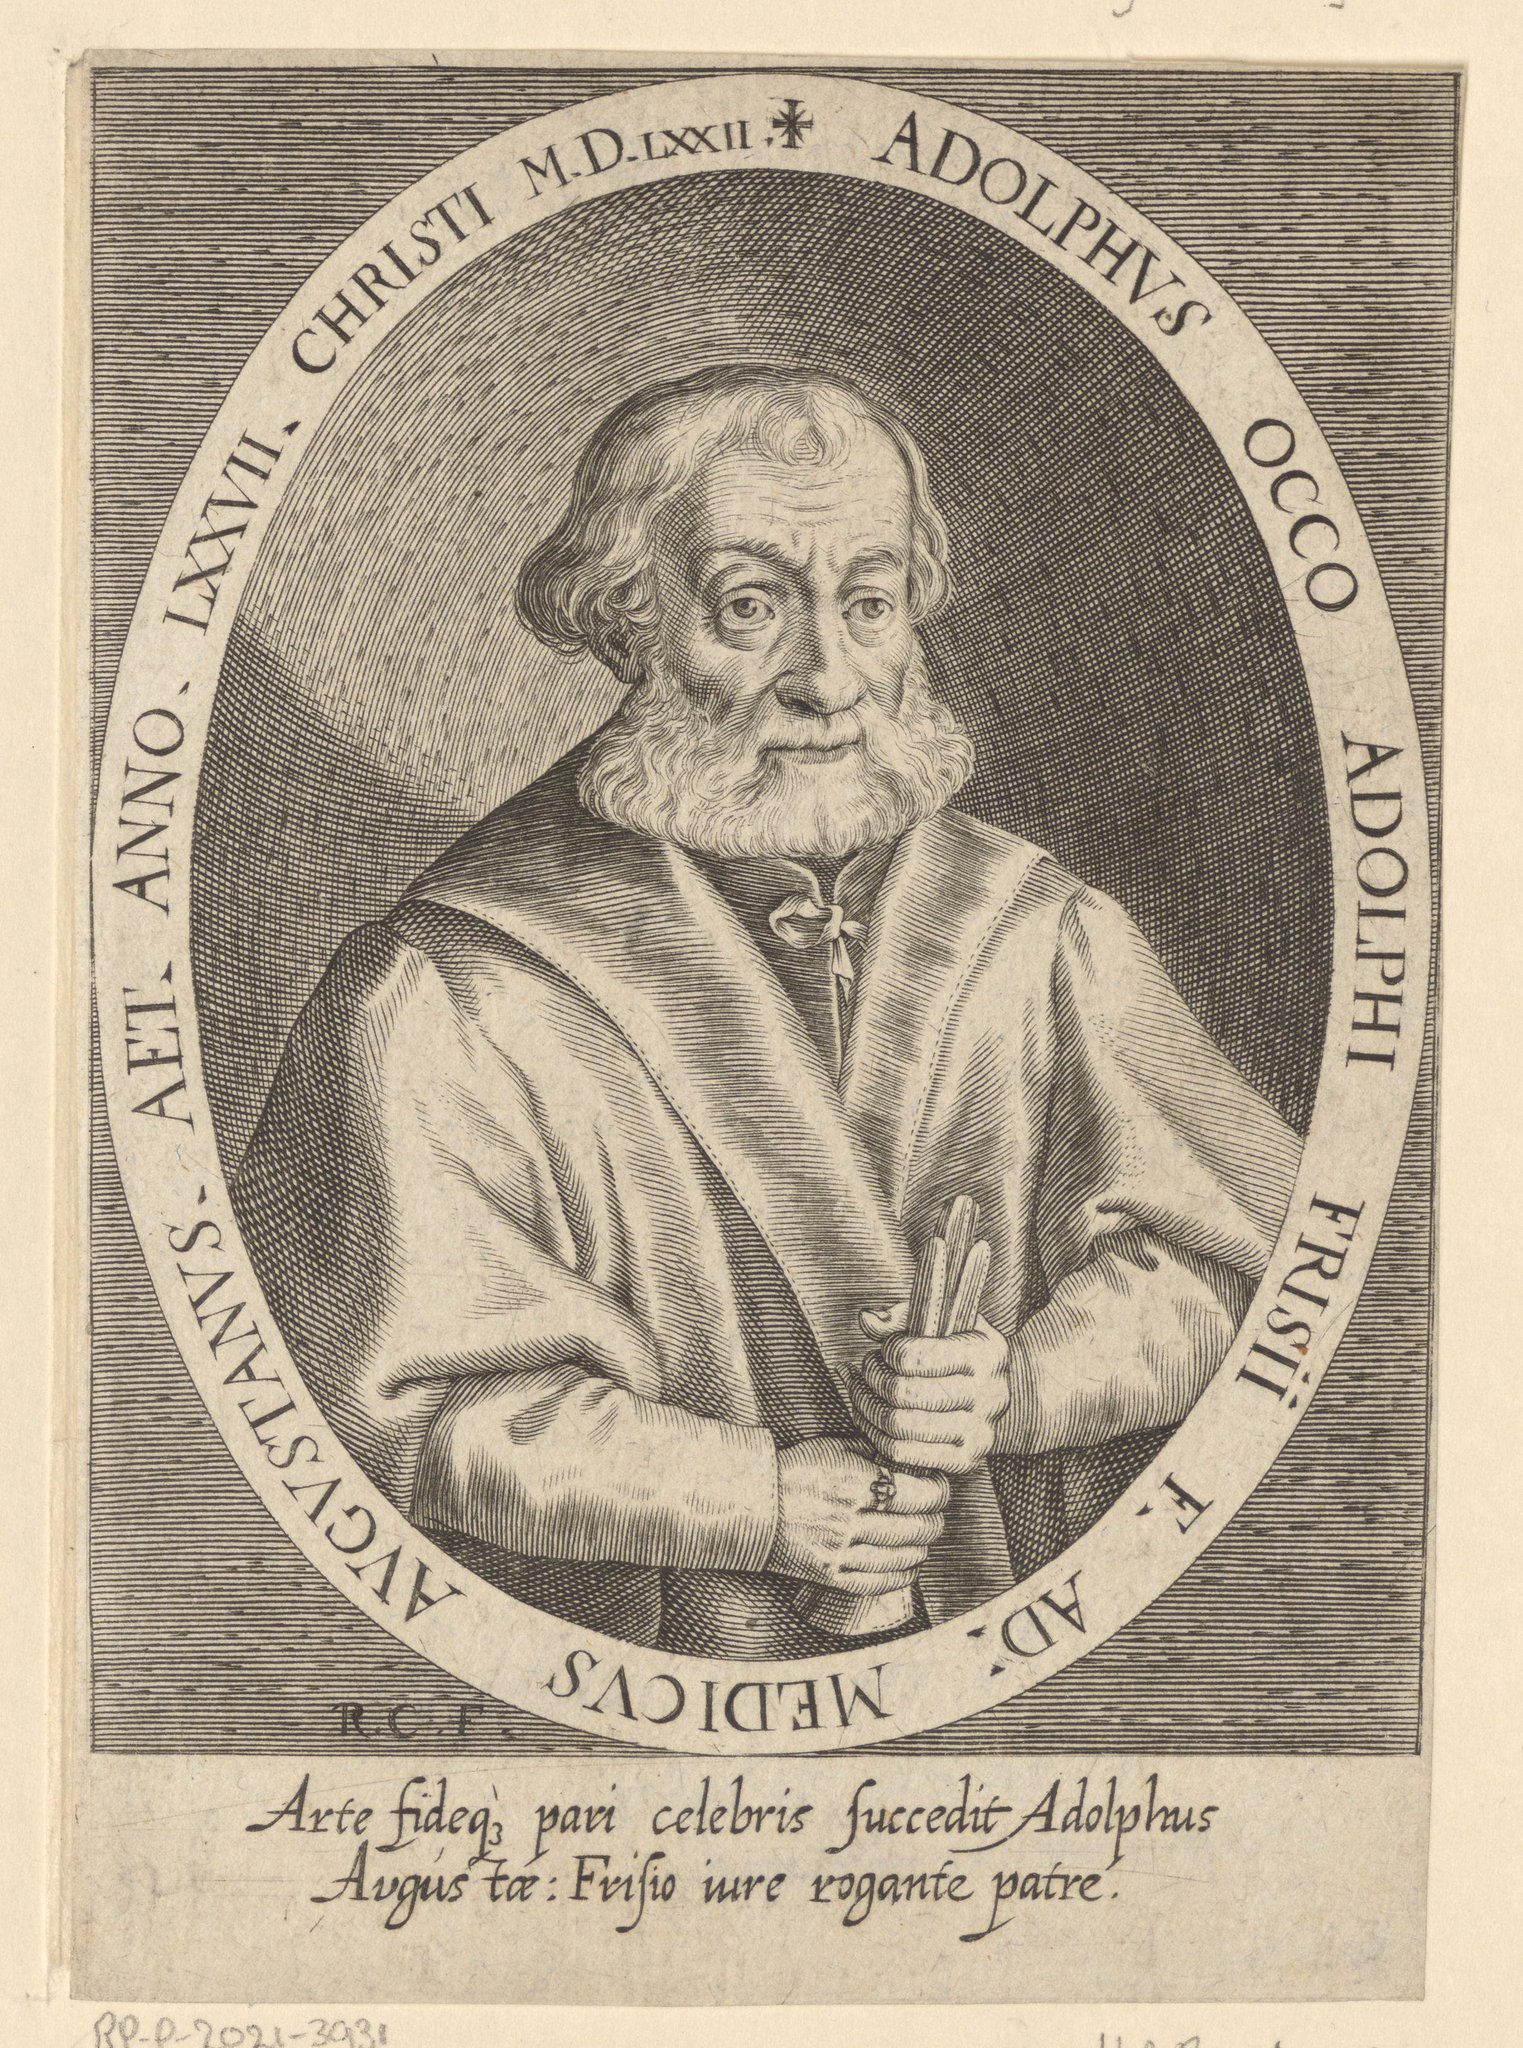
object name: print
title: Portret van Adolph Occo II op 77-jarige leeftijd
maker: raphael custos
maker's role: print maker, publisher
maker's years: 1590-1664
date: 1612-1664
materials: paper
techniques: engraving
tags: augsburg, gloves, mittens, etc., historical persons